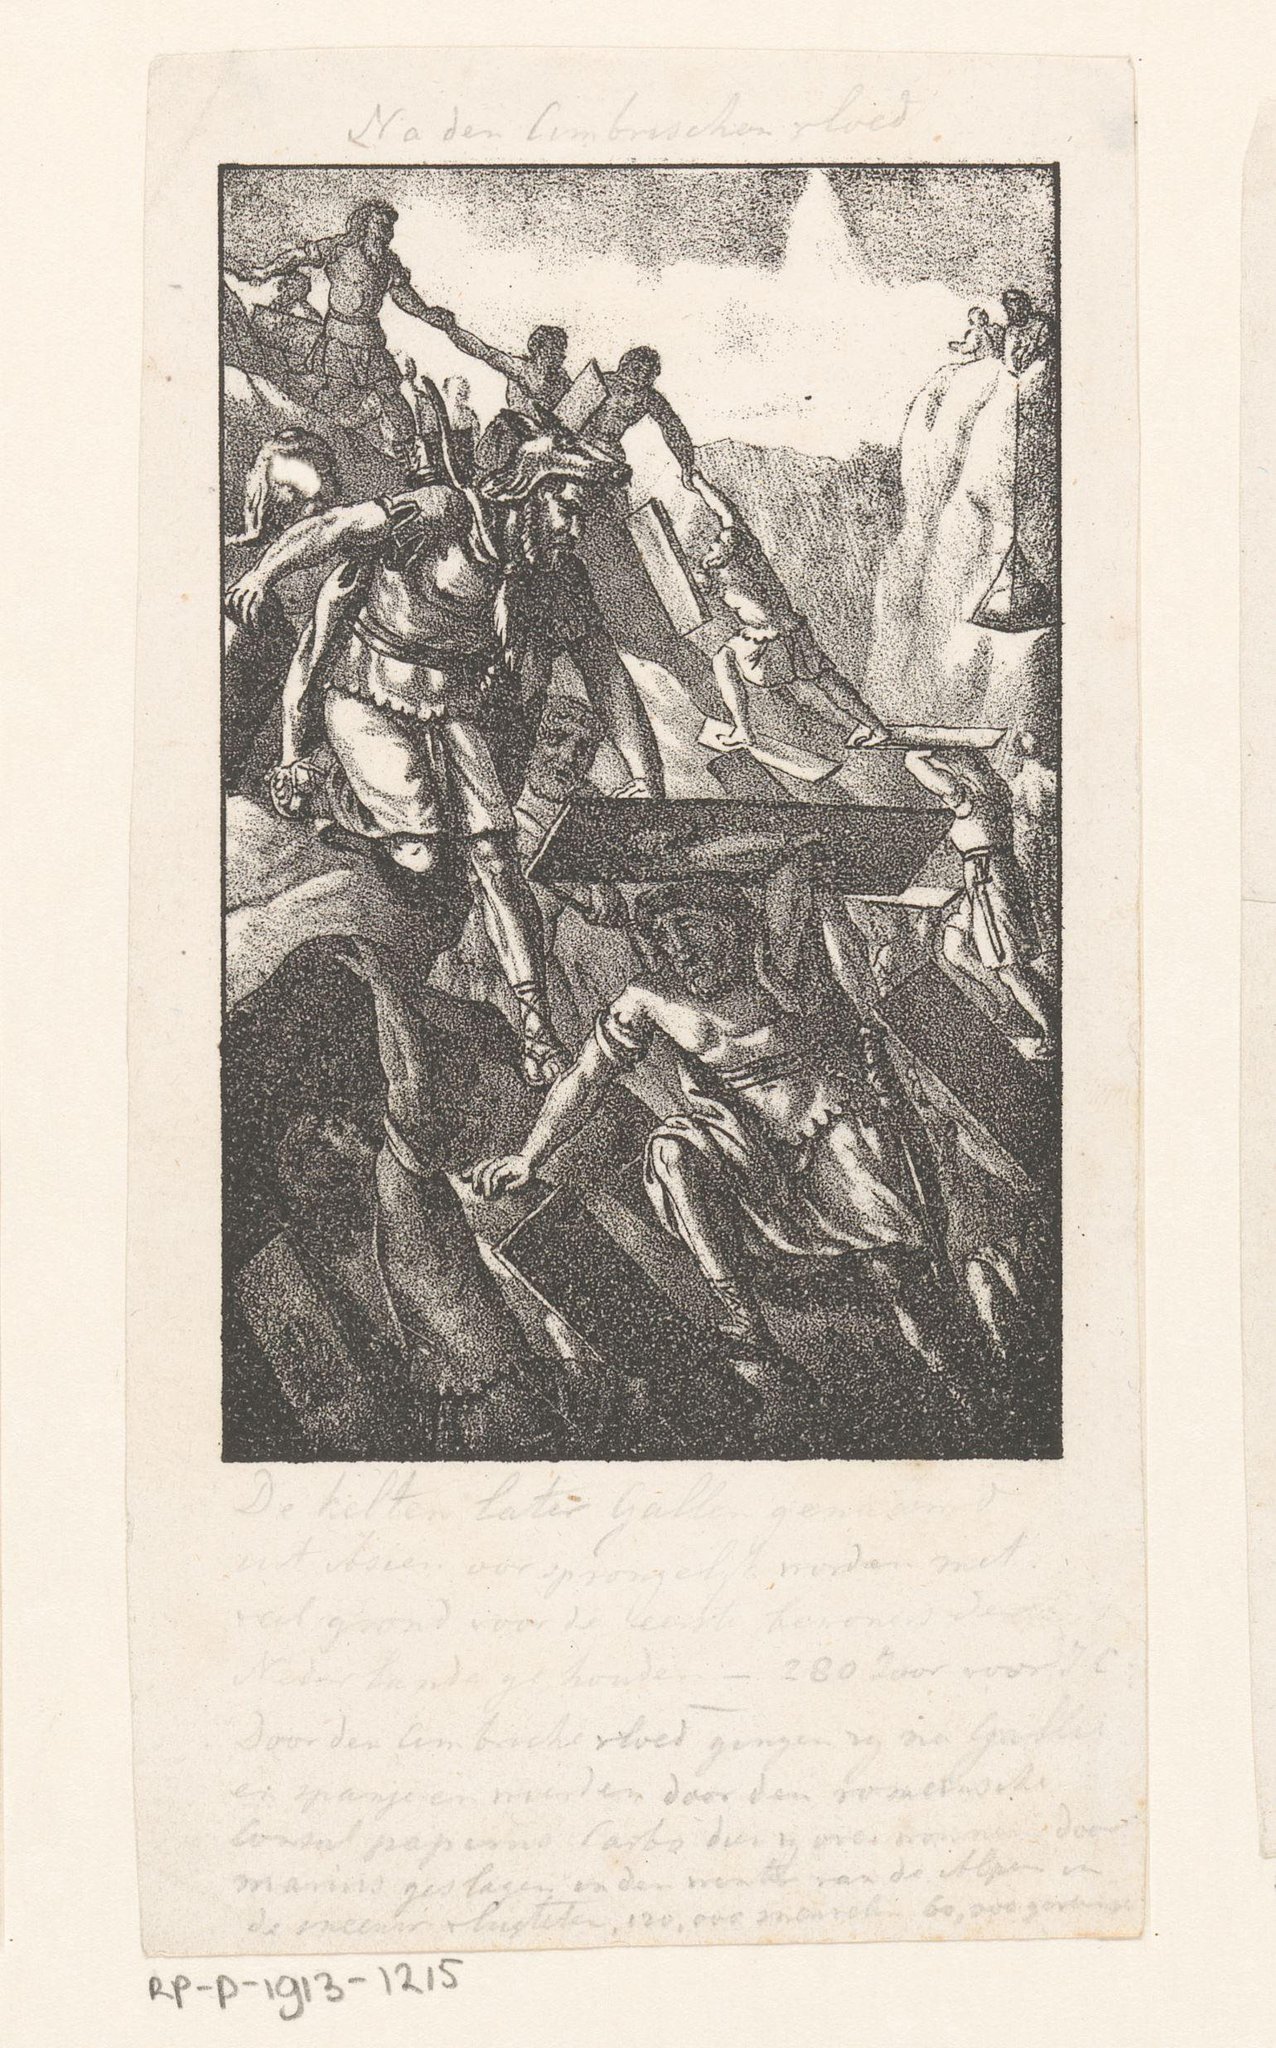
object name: print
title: Plunderende Kelten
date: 1809-1899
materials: paper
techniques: lithograph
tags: celtic religion, plundering ~ riot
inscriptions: collector's mark: Lugt 2228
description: In het inventarisboek wordt vermeld dat de prenten werden gemaakt voor een geschiedenisboek.